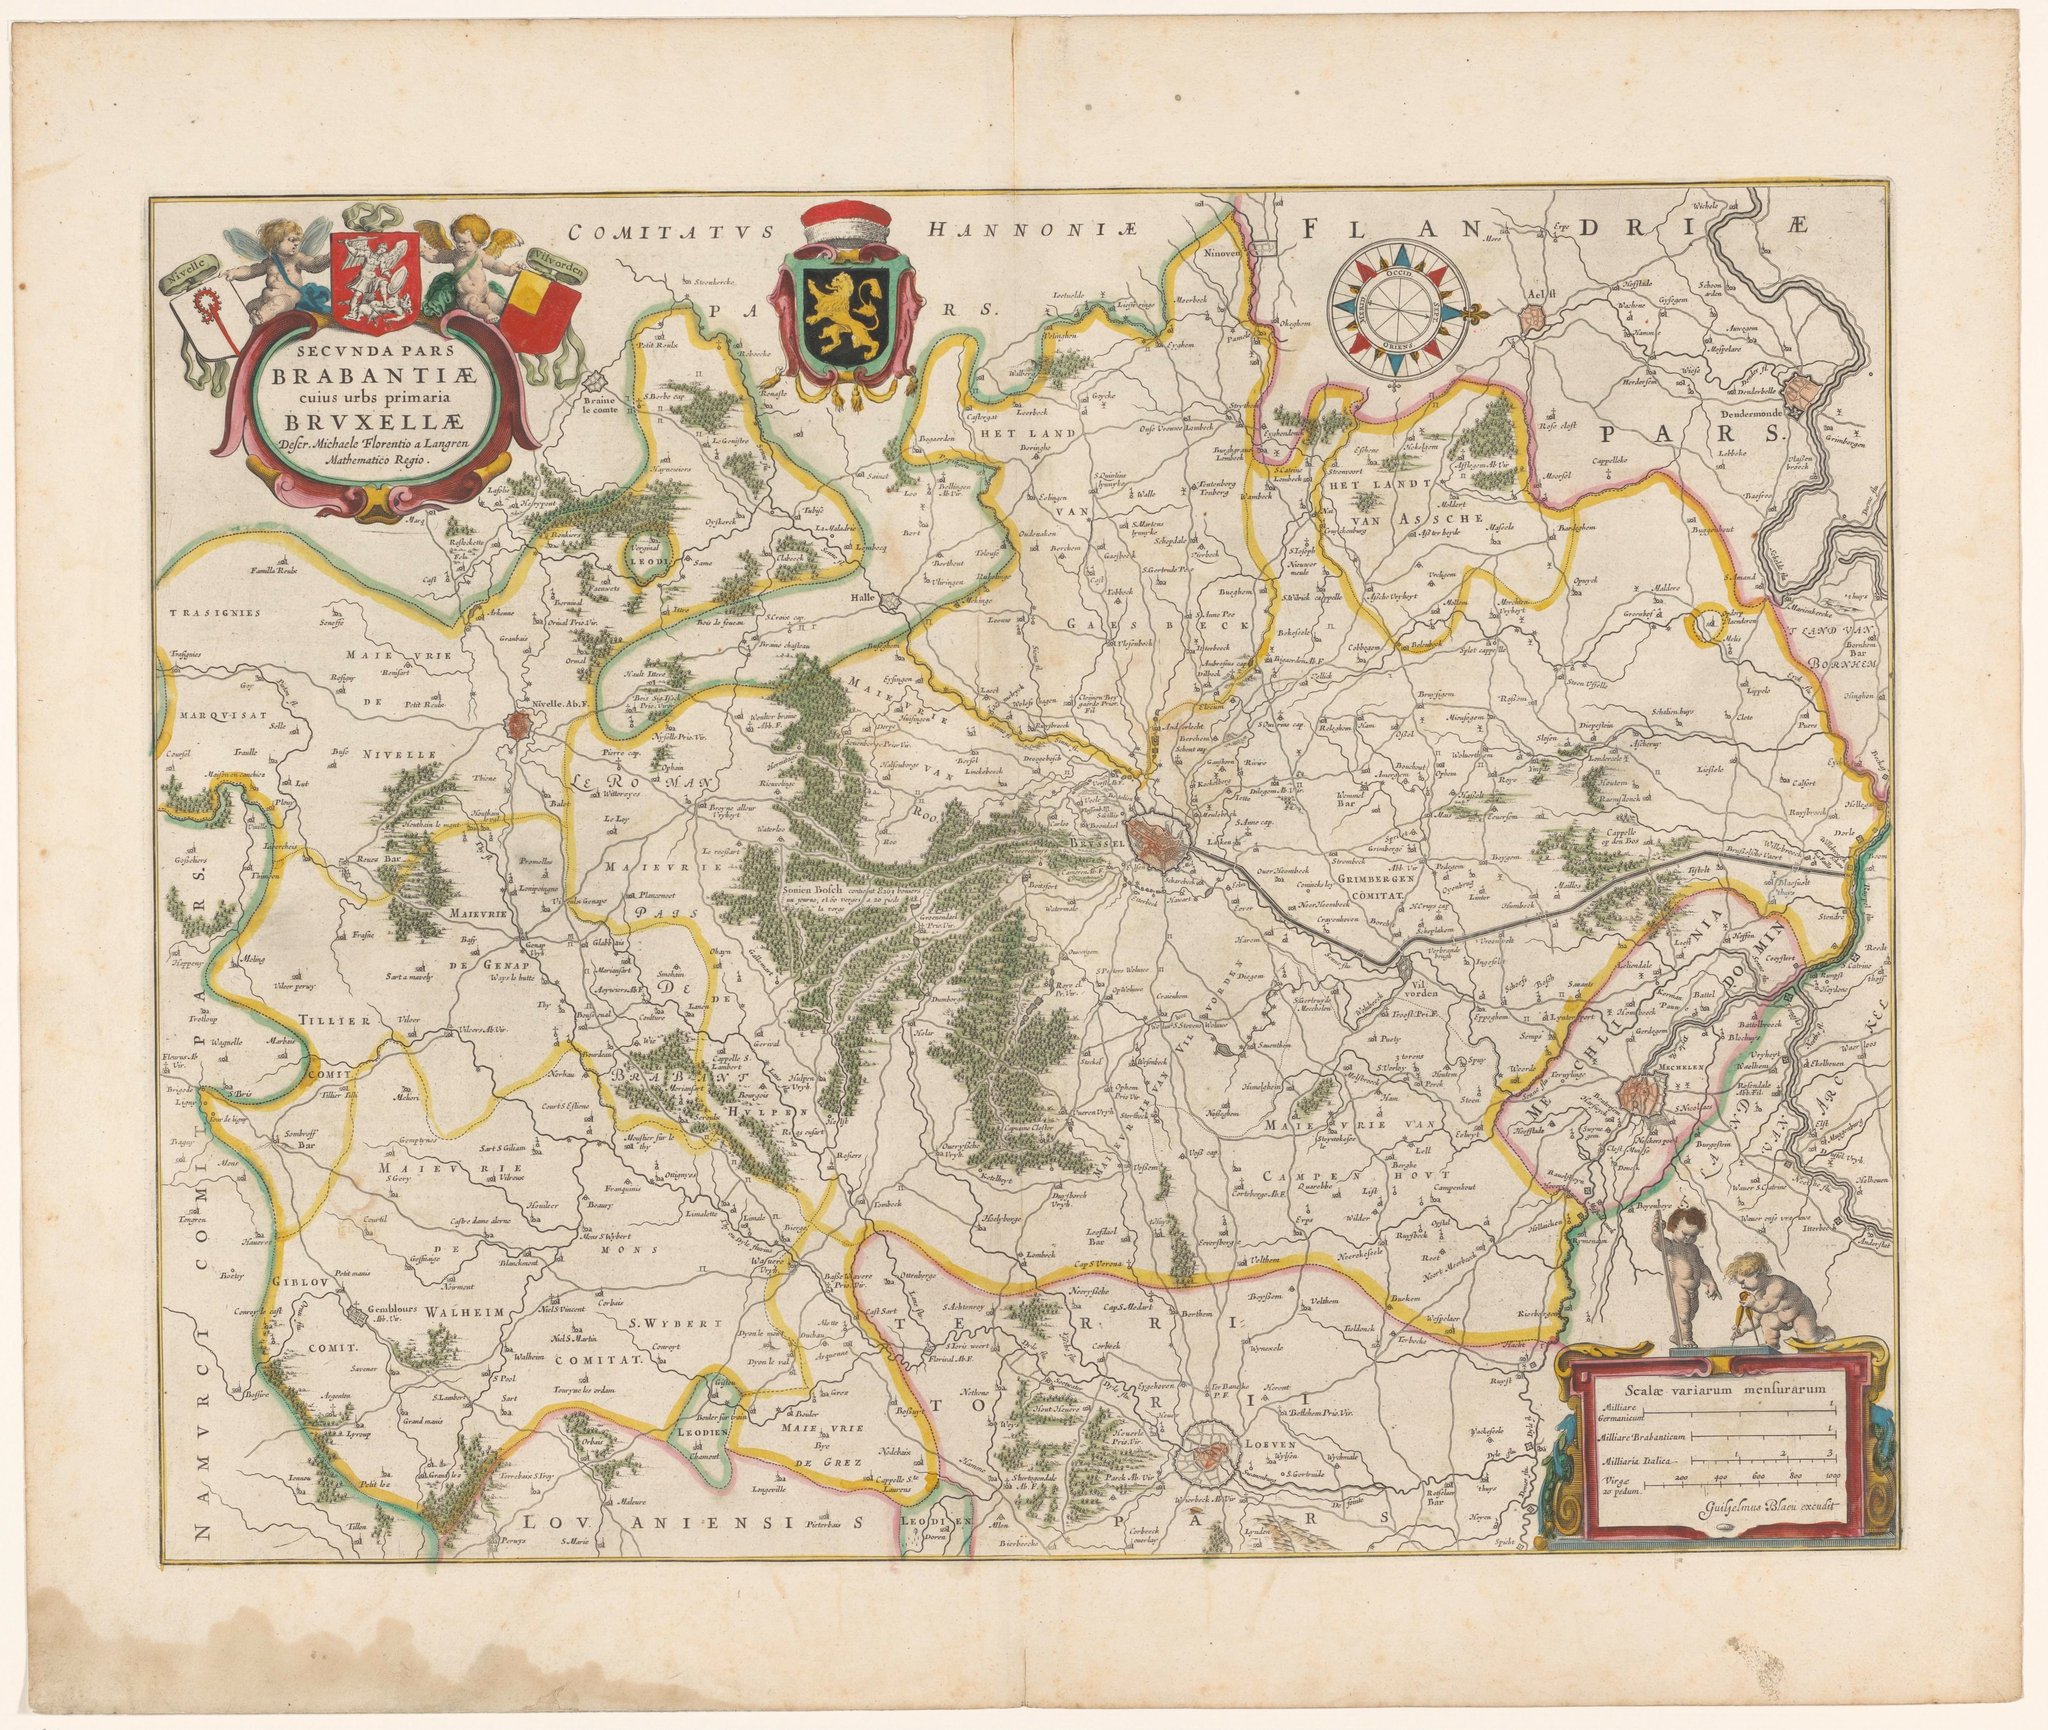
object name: print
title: Kaart van het kwartier van Brussel, onderdeel van het hertogdom Brabant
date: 1642-1664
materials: paper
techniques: engraving, etching, hand coloring, letterpress printing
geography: amsterdam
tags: coat of arms (as symbol of the state, etc.) (+ city; municipal), maps of separate countries or regions, coat of arms (as symbol of the state, etc.) (+ province; provincial), brabant, brussels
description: Huidige staat van prent gebruikt in: Blaeu, Willem Janszoon en Johannes Willemszoon Blaeu. Toonneel des aerdriicx, ofte nieuwe Atlas, dat is de beschryving van alle landen. 3 delen. Amsterdam: Johannes Willemszoon Blaeu, 1642-1643, dl. 1 (1642). Of in: Blaeu, Willem Janszoon en Johannes Willemszoon Blaeu. Toonneel des aerdrycx, ofte nieuwe Atlas, dat is de beschryving van alle landen. 4 delen. Amsterdam: Johannes Willemszoon Blaeu, 1647-1650, dl. 1 (1647-1648). Of in: Blaeu, Willem Janszoon en Johannes Willemszoon Blaeu. Toonneel des aerdrycx, ofte nieuwe Atlas, dat is de beschryving van alle landen. 4 delen. Amsterdam: Johannes Willemszoon Blaeu, 1649-1650, dl. 1 (1649). Of in: Blaeu, Willem Janszoon en Johannes Willemszoon Blaeu. Toonneel des aerdriicx, ofte niuew Atlas, dat is beschryving van alle landen. 6 delen. Amsterdam: Johannes Willemszoon Blaeu, 1658-1661, dl. 1. Of in: Blaeu, Johannes Willemszoon. J. Blaeus grooten atlas oft wereltbeschyving, in welcke 't aerdryck, de zee, en hemel, wort vertoont en beschreven. 9 delen. Amsterdam: Johannes Willlemszoon Blaeu, 1664-1665, dl. 3 (1664).